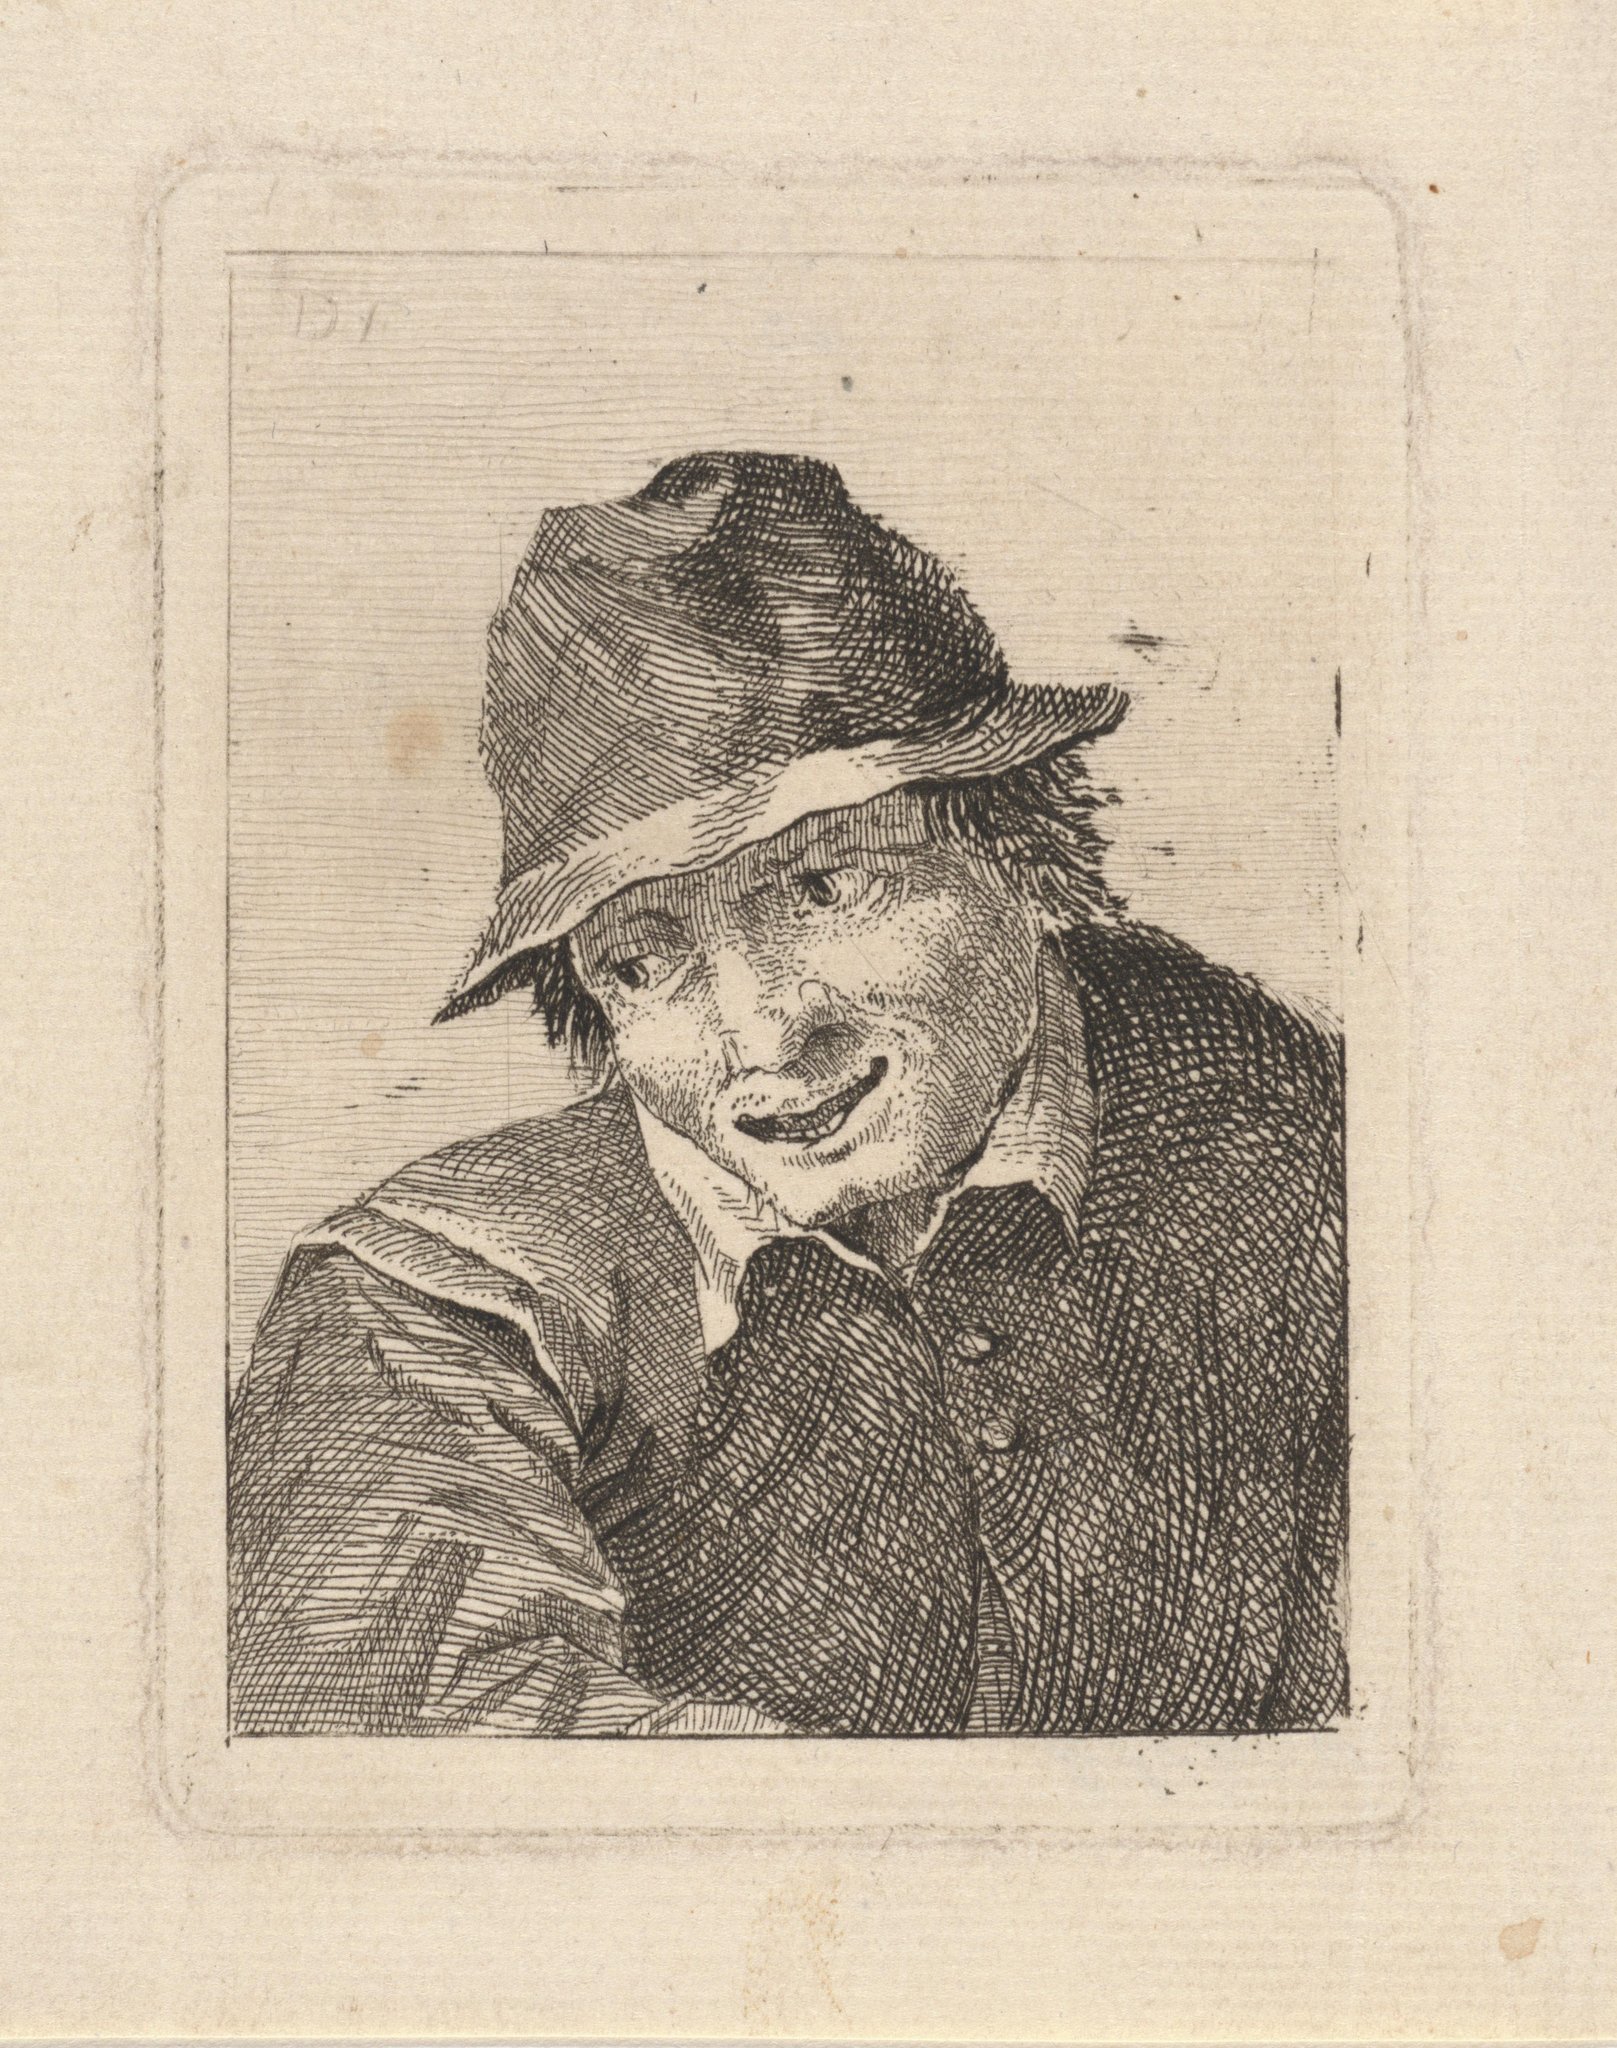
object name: print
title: Buste van een man met hoed kijkend naar rechts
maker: Anonymous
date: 1700-1799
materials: paper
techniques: etching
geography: low countries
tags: head-gear: hat (+ men's clothes)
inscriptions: collector's mark: Lugt 2228